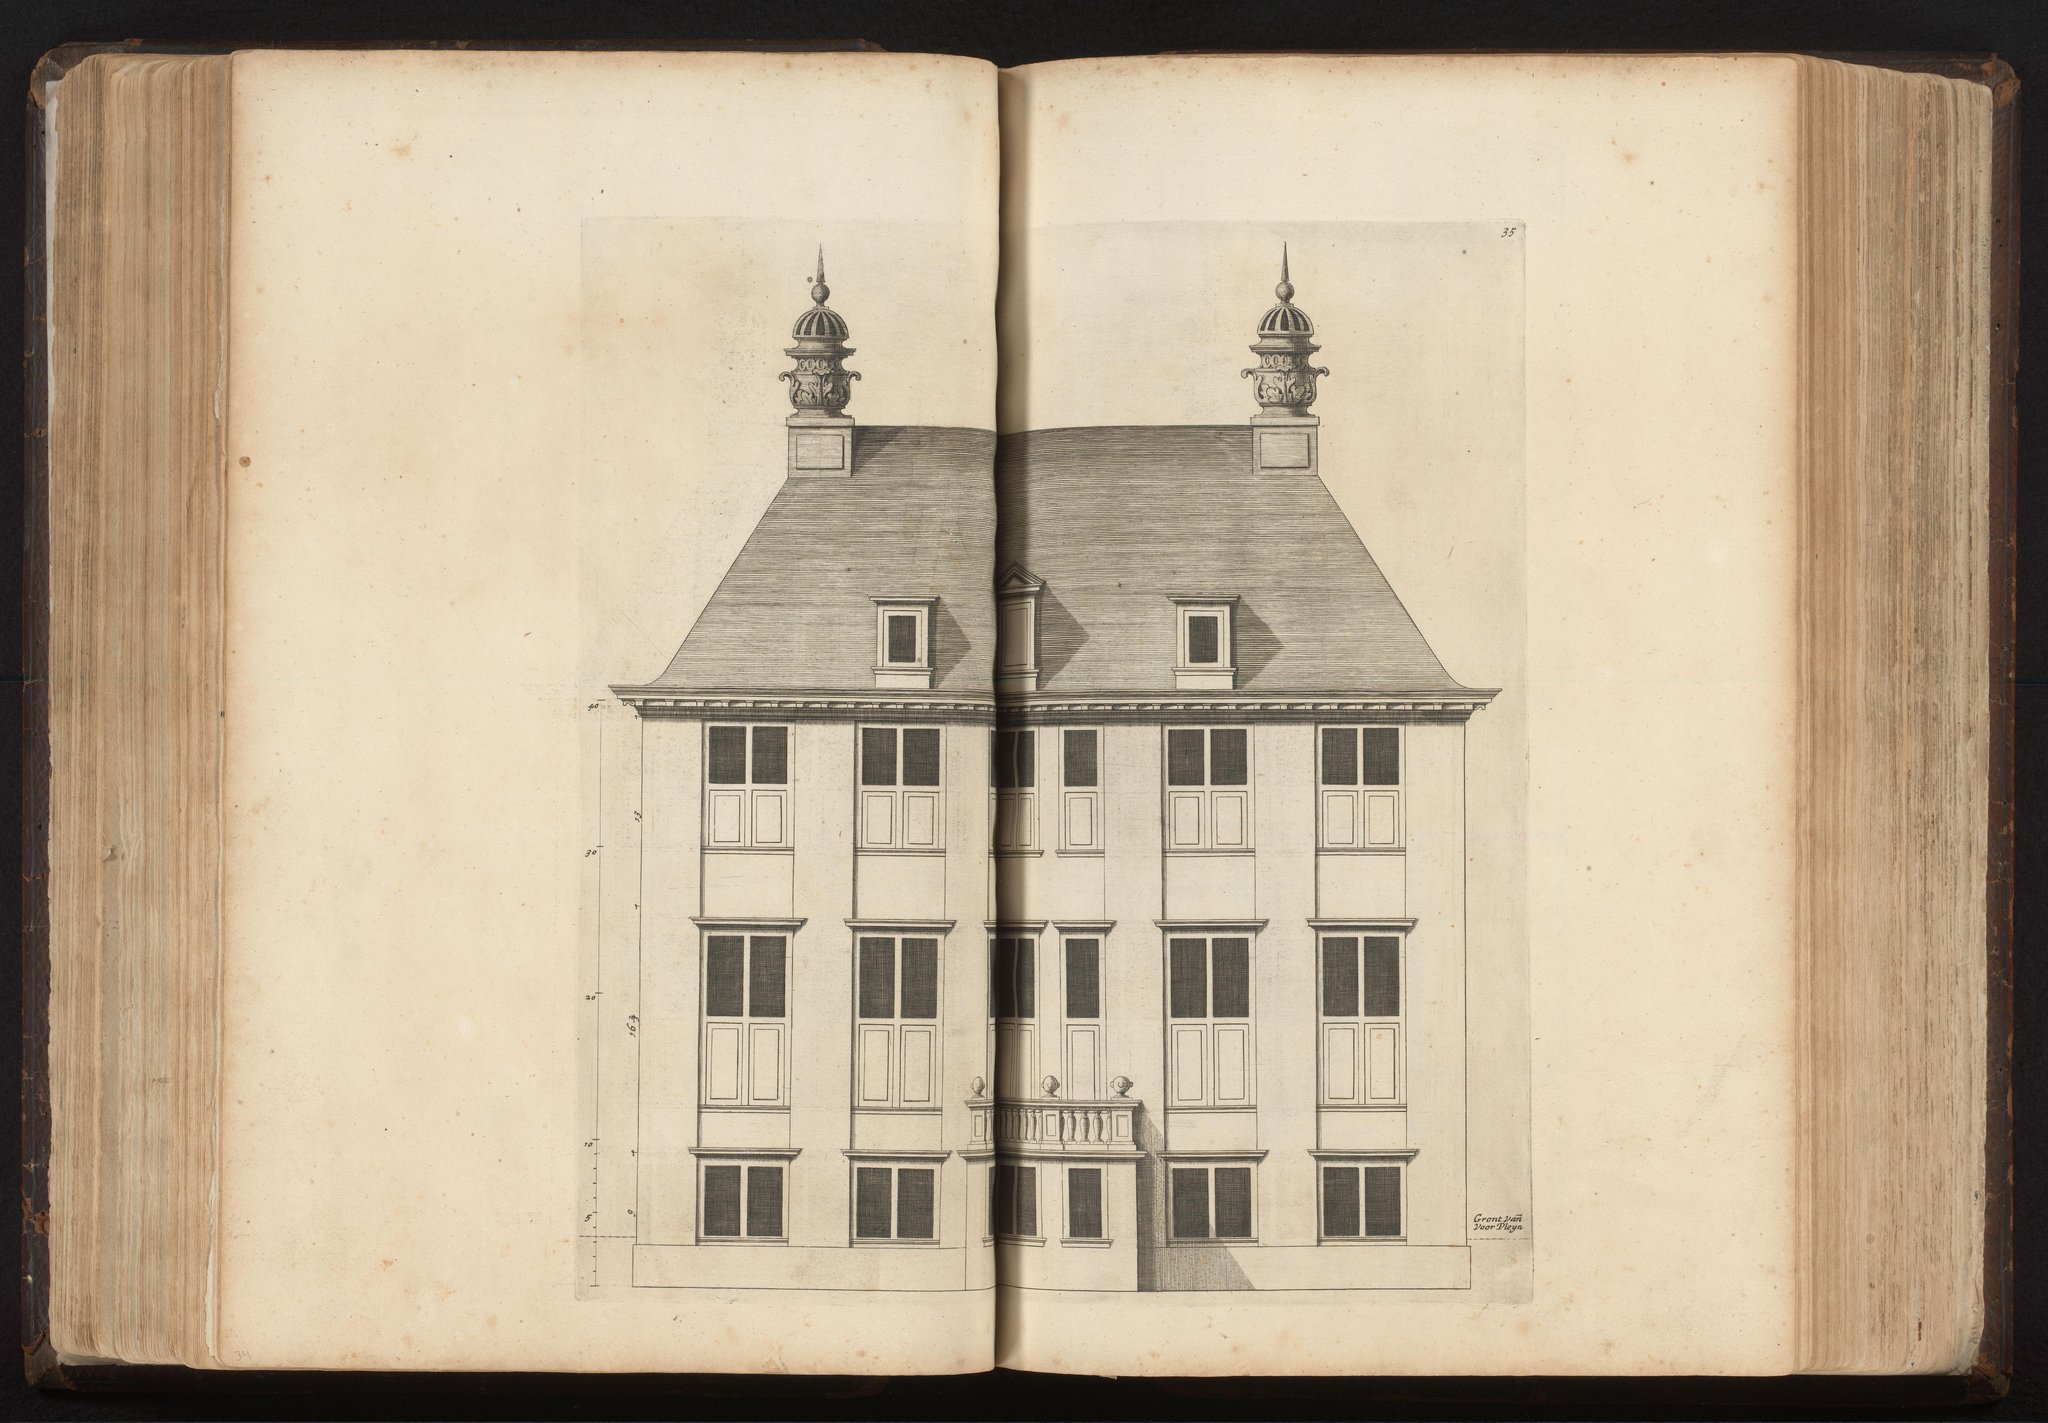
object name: book illustration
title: Achtergevel van het landhuis Vredenburg in de Beemster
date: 1648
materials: paper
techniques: engraving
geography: amsterdam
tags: country-house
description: Prent uit: Afbeelsels der voornaemste gebouwen uyt alle die Philips Vingboons geordineert heeft. Amsterdam: Philips en Johannes Vinckboons en Johannes Willemszoon Blaeu, 1648.